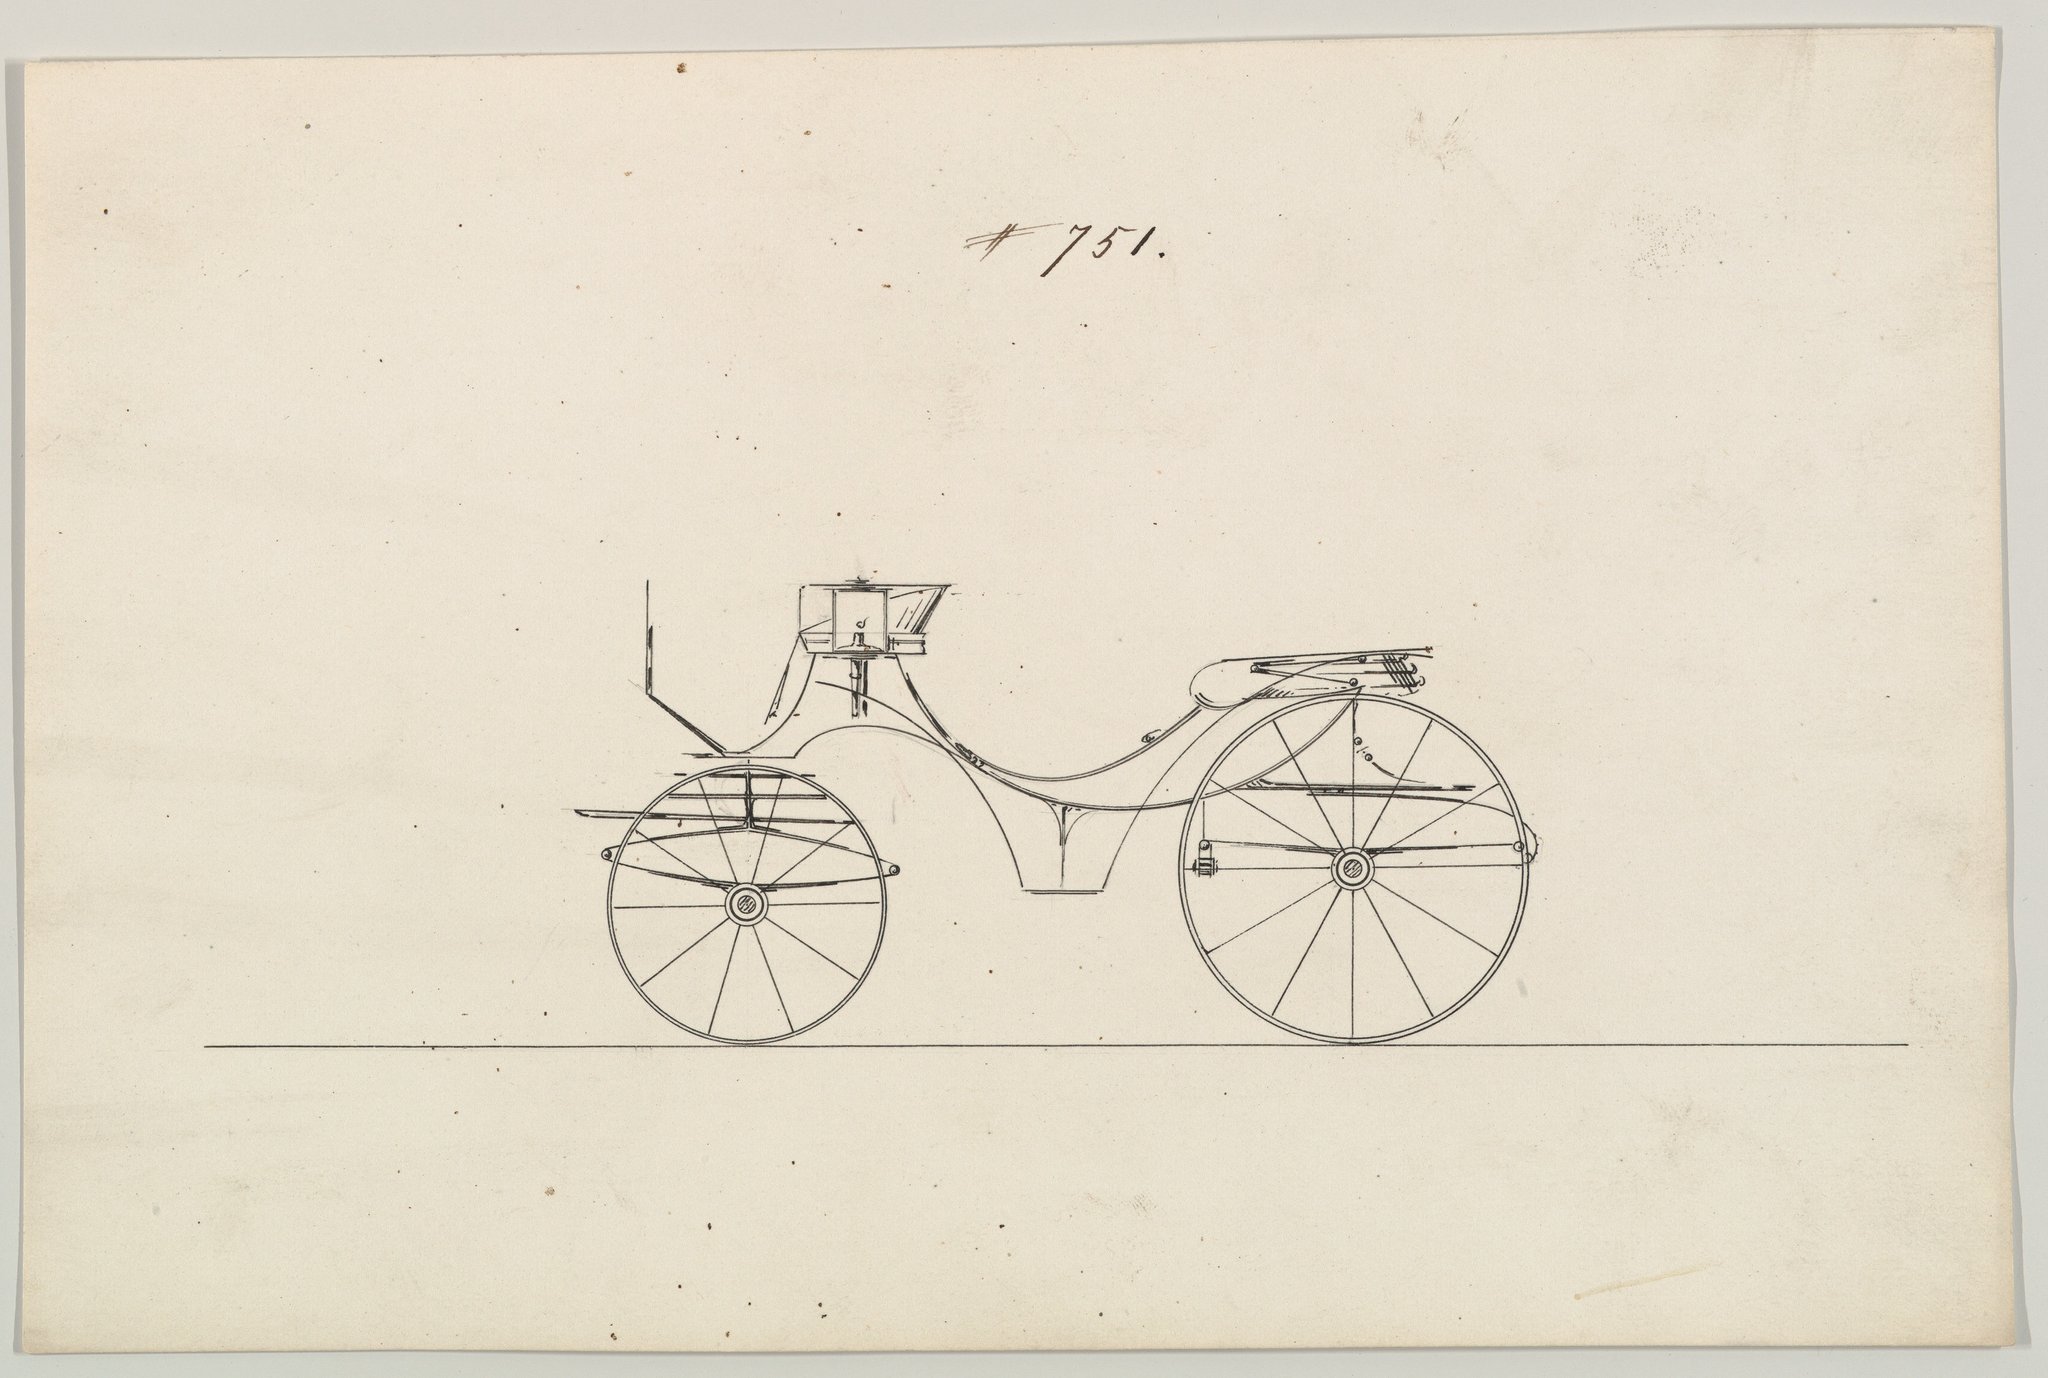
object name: drawing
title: Cabriolet #751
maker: brewster & co.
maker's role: manufacturer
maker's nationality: american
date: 1870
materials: graphite, ink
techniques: pen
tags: carriages